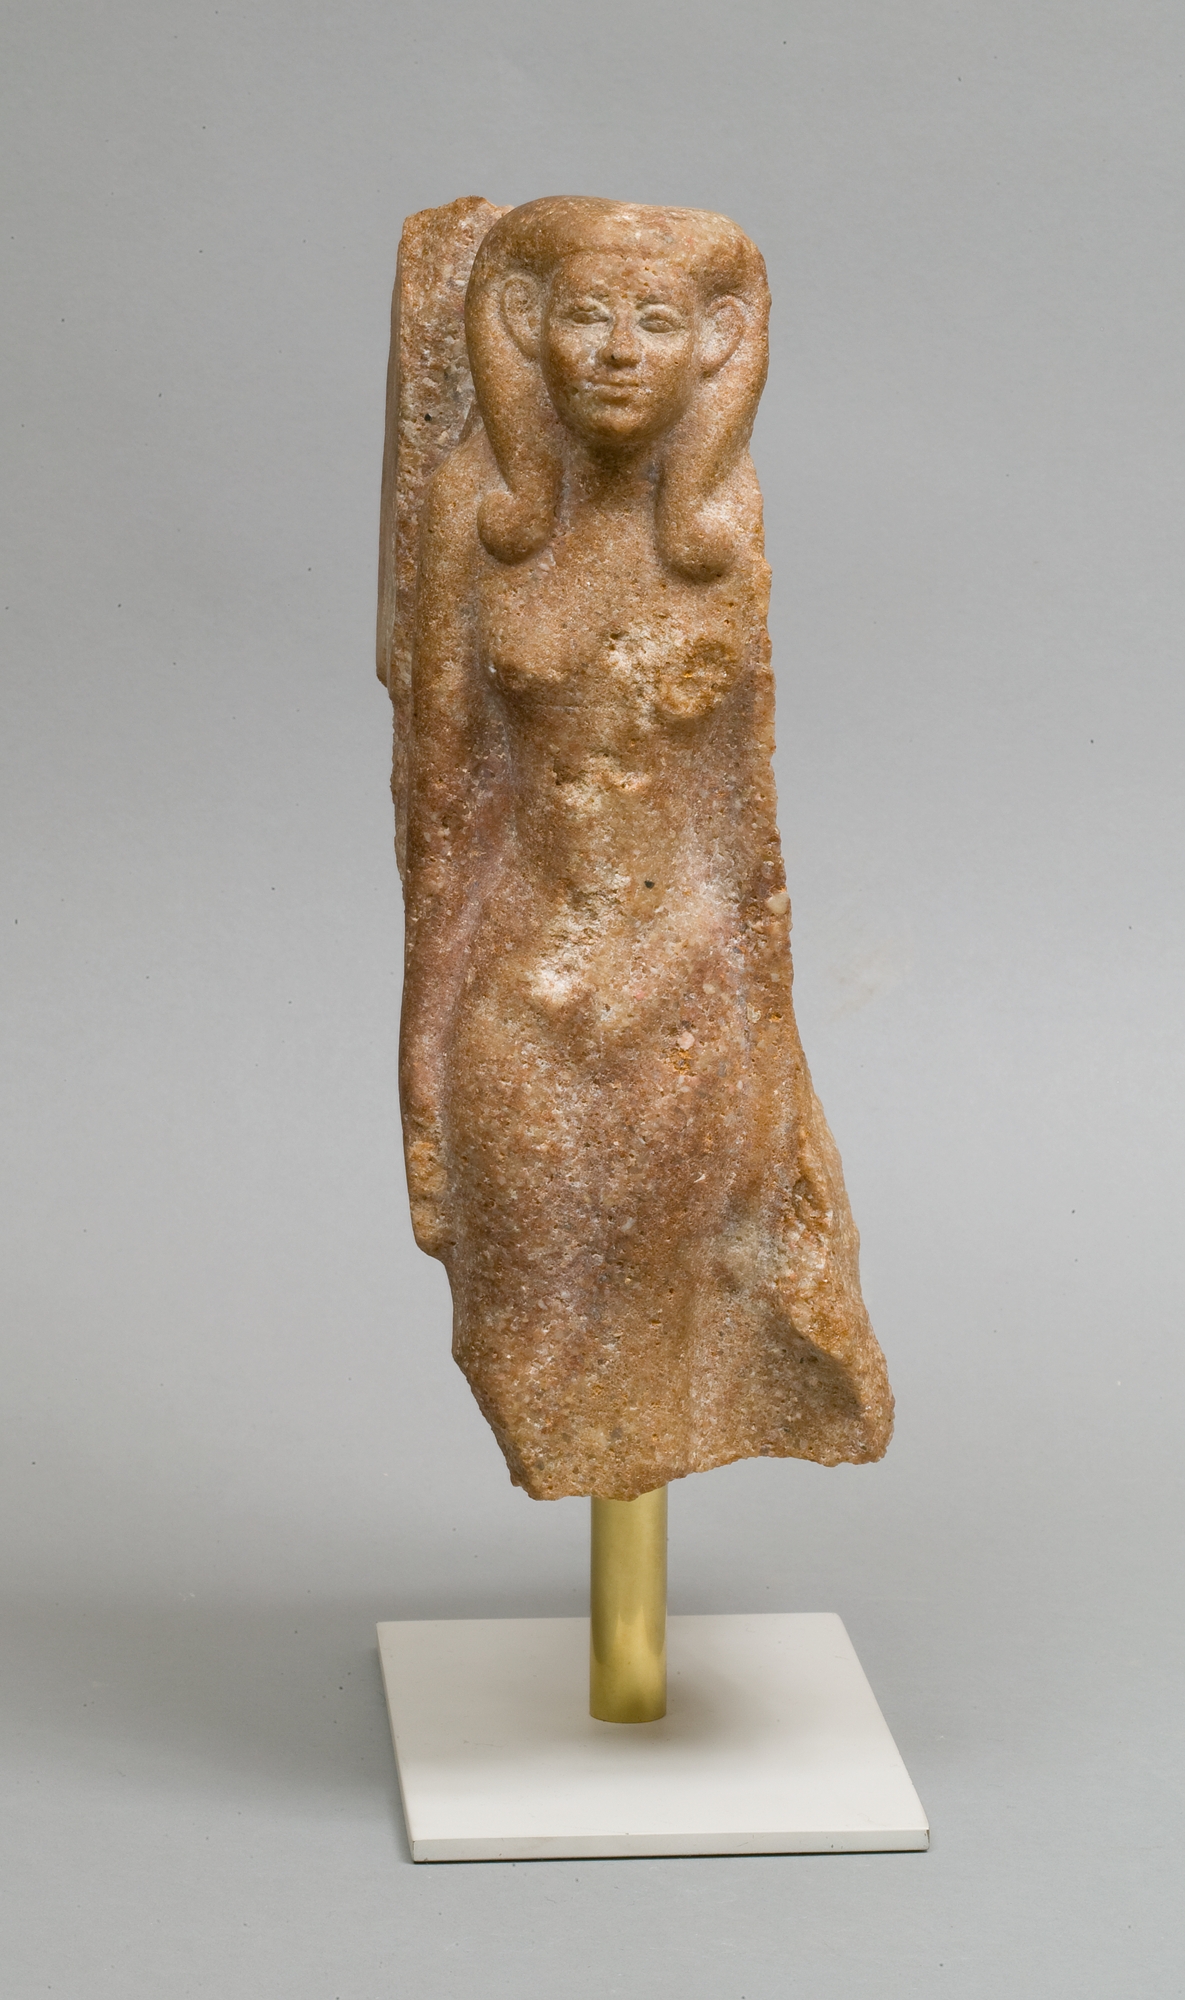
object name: statuette of a woman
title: Female figure from a group statue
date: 1981-1640 BCE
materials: quartzite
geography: egypt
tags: women